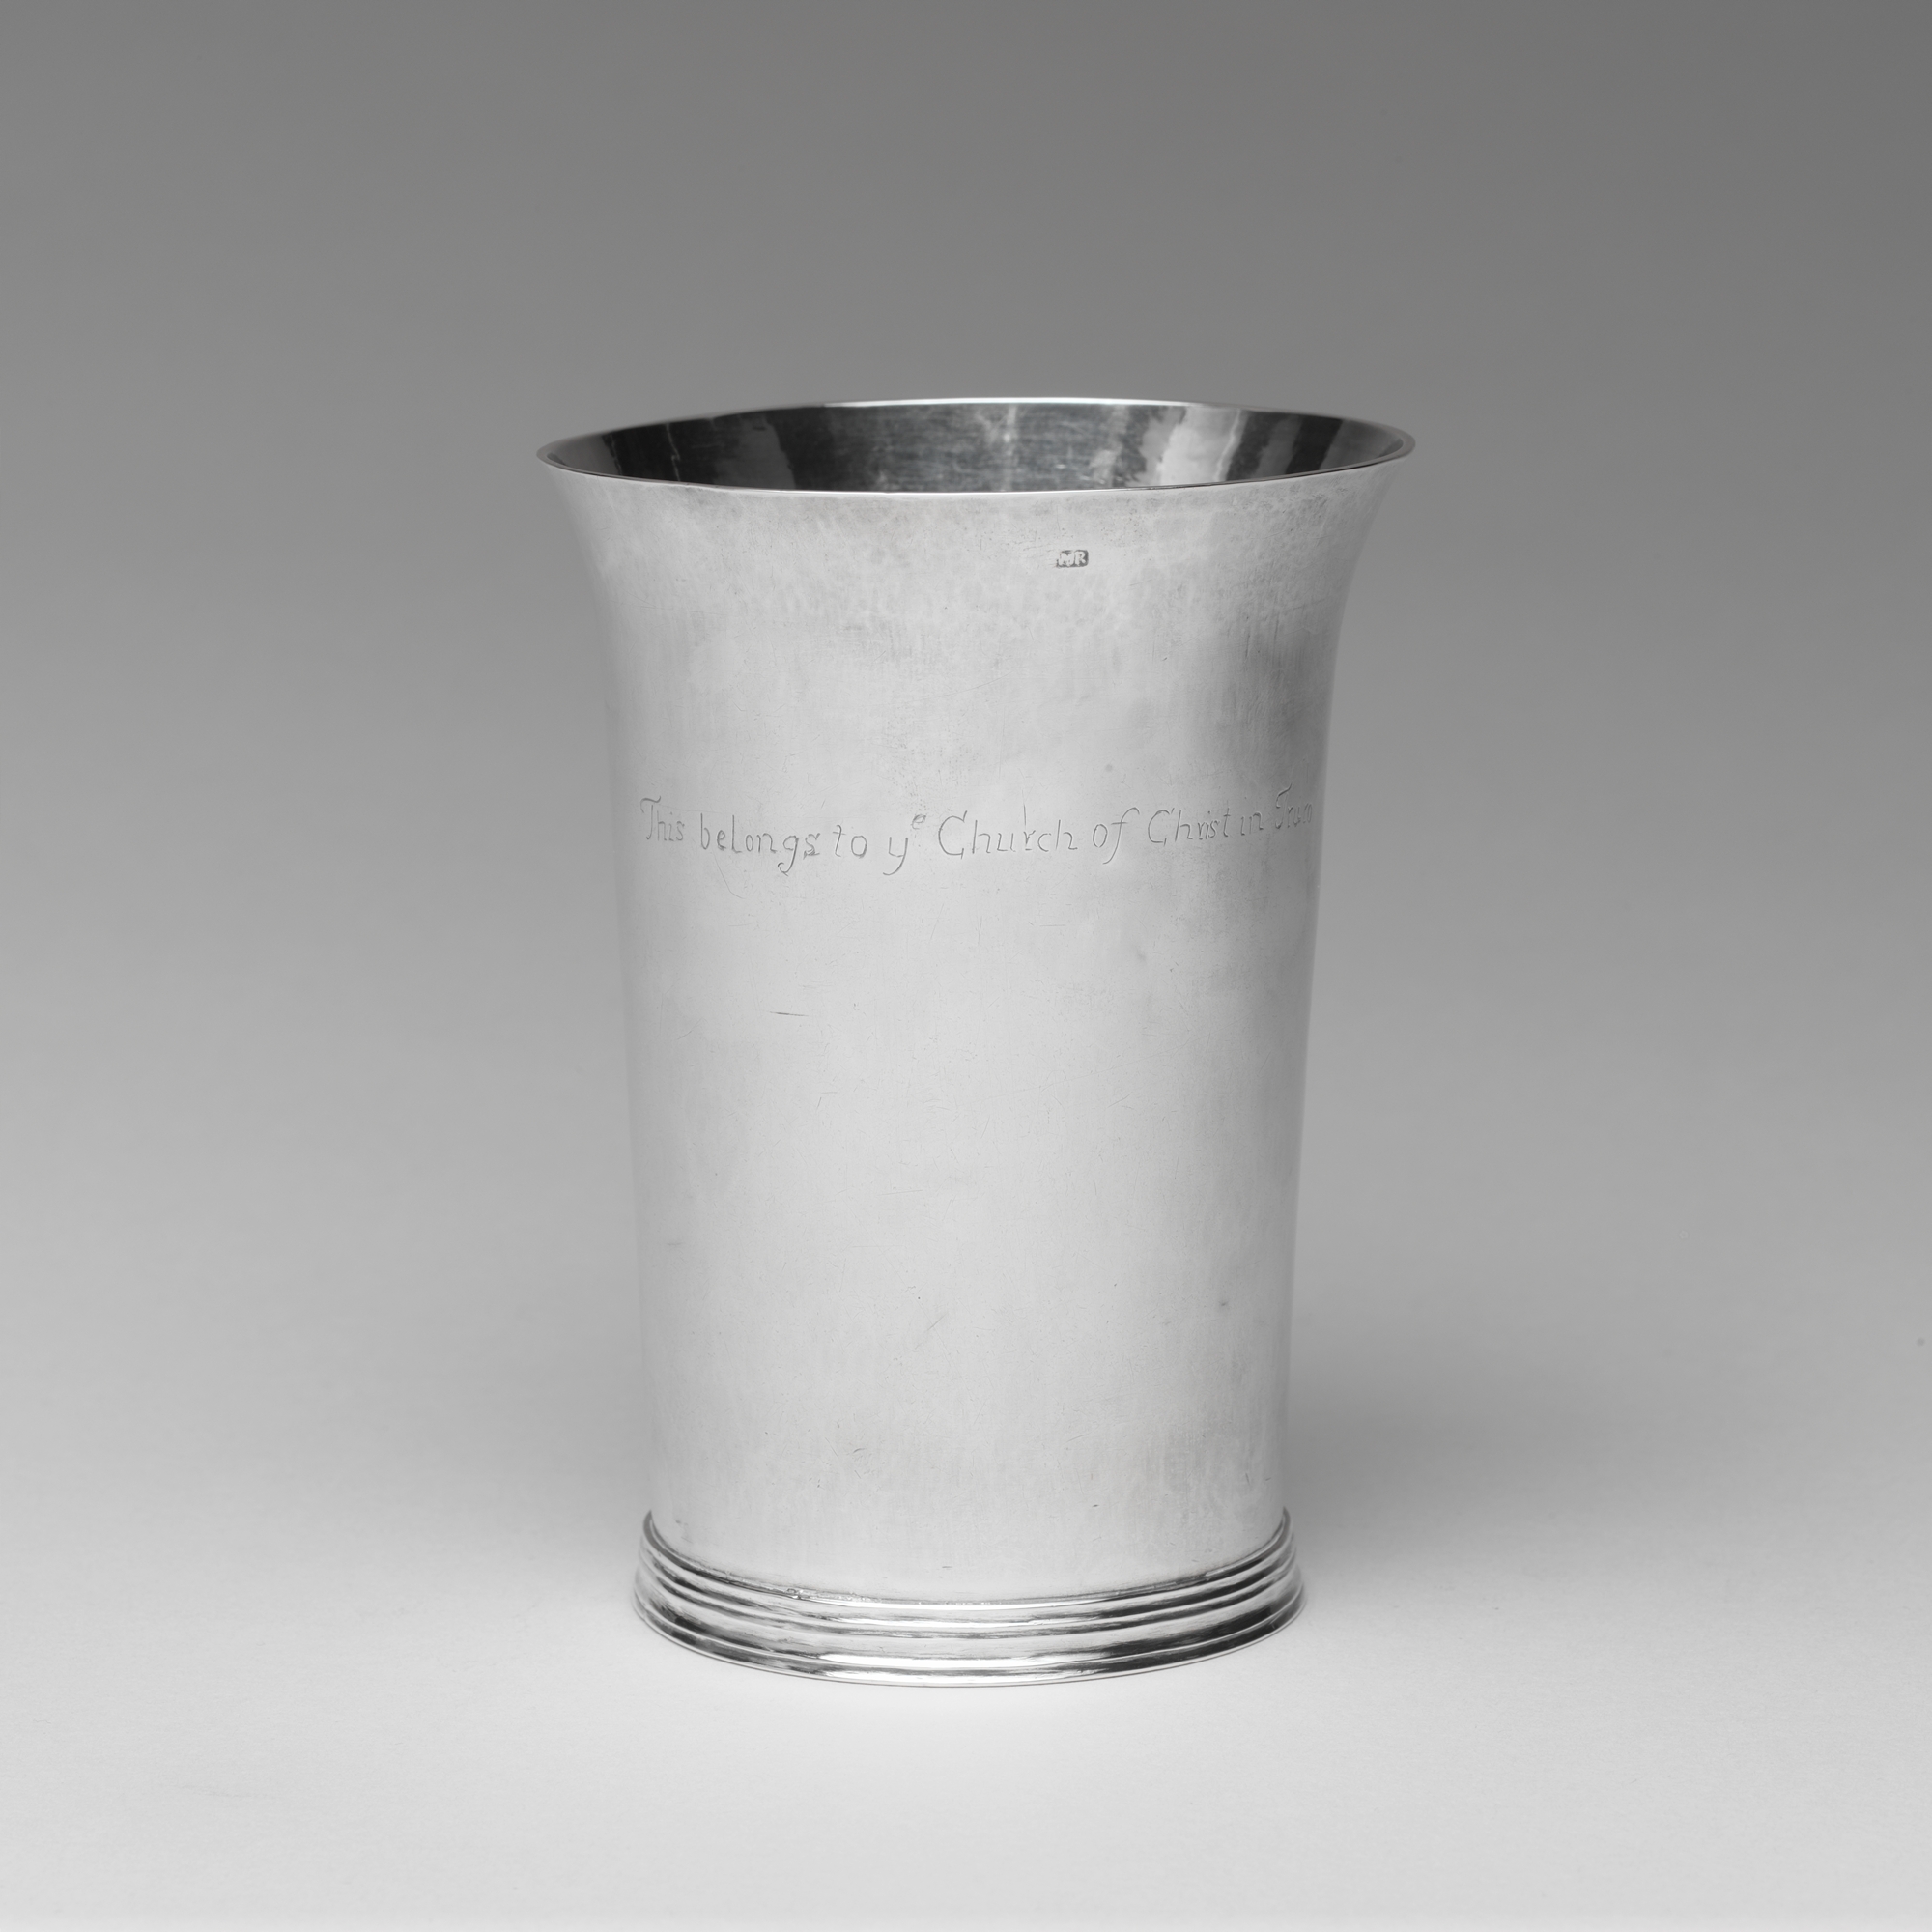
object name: beaker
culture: american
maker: moody russell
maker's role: maker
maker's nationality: american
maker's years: 1694-1761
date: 1715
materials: silver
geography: united states